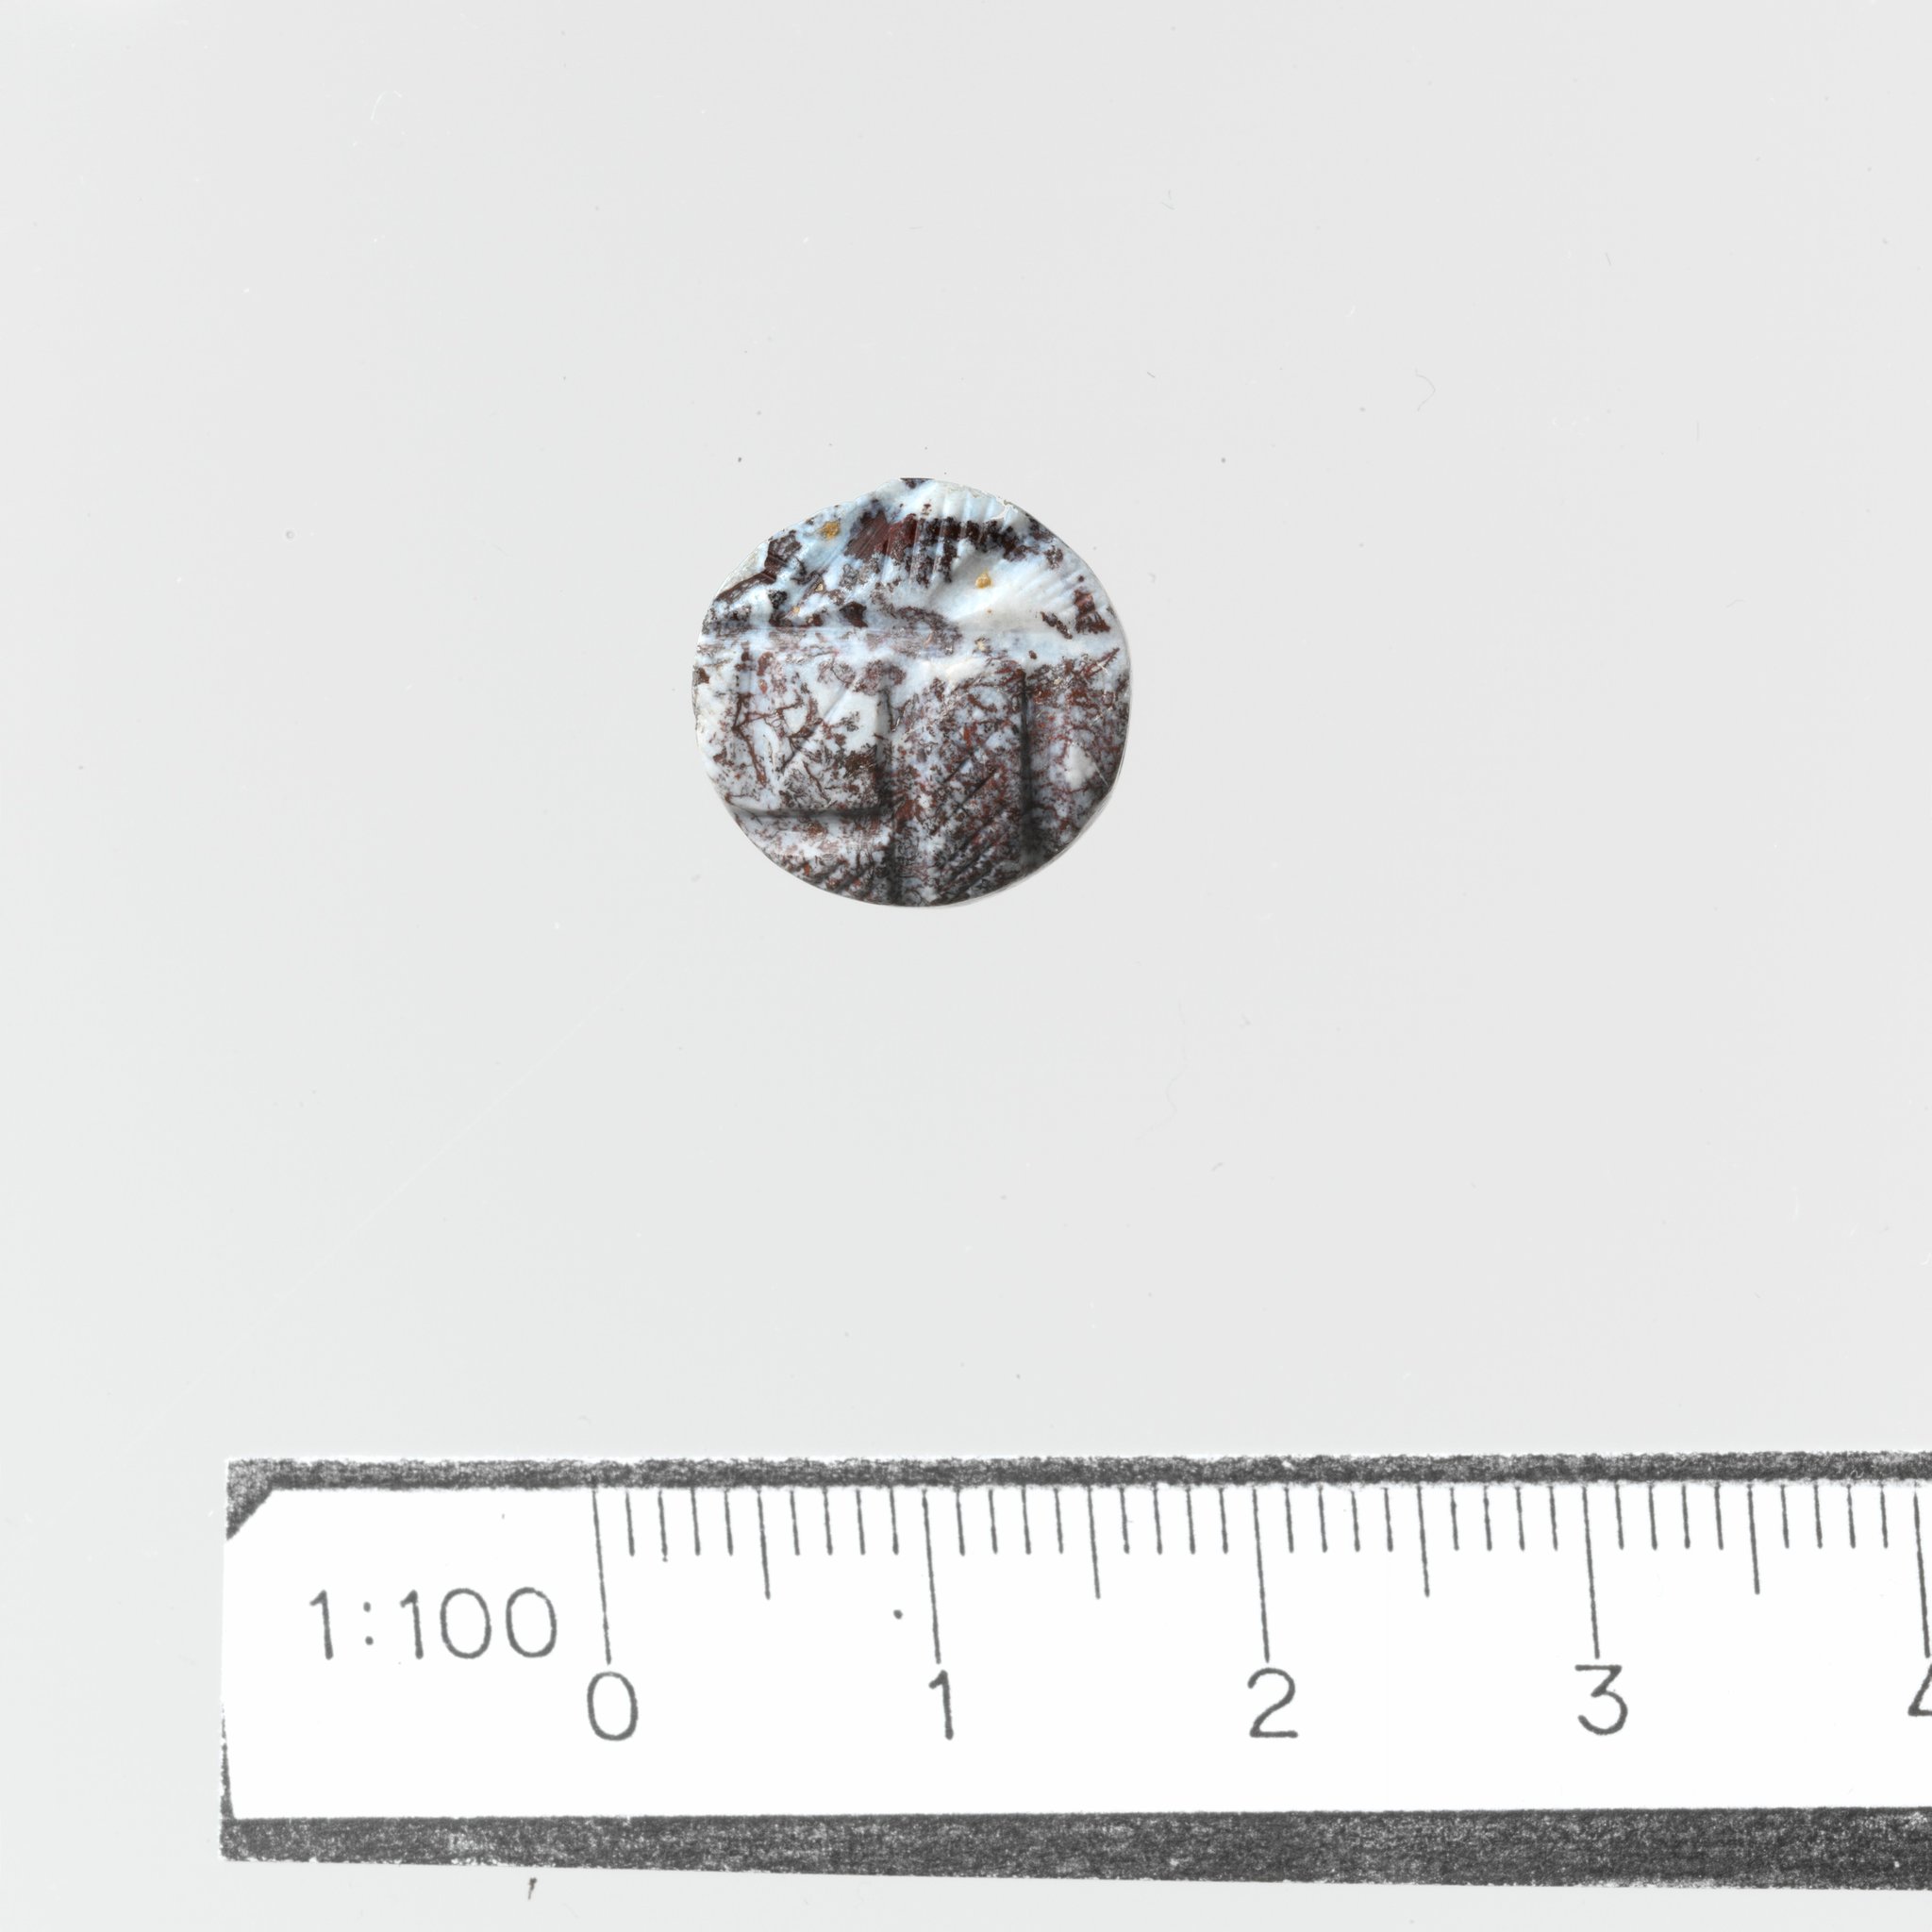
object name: seal, discoid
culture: minoan, crete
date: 1650-1500 BCE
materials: jasper